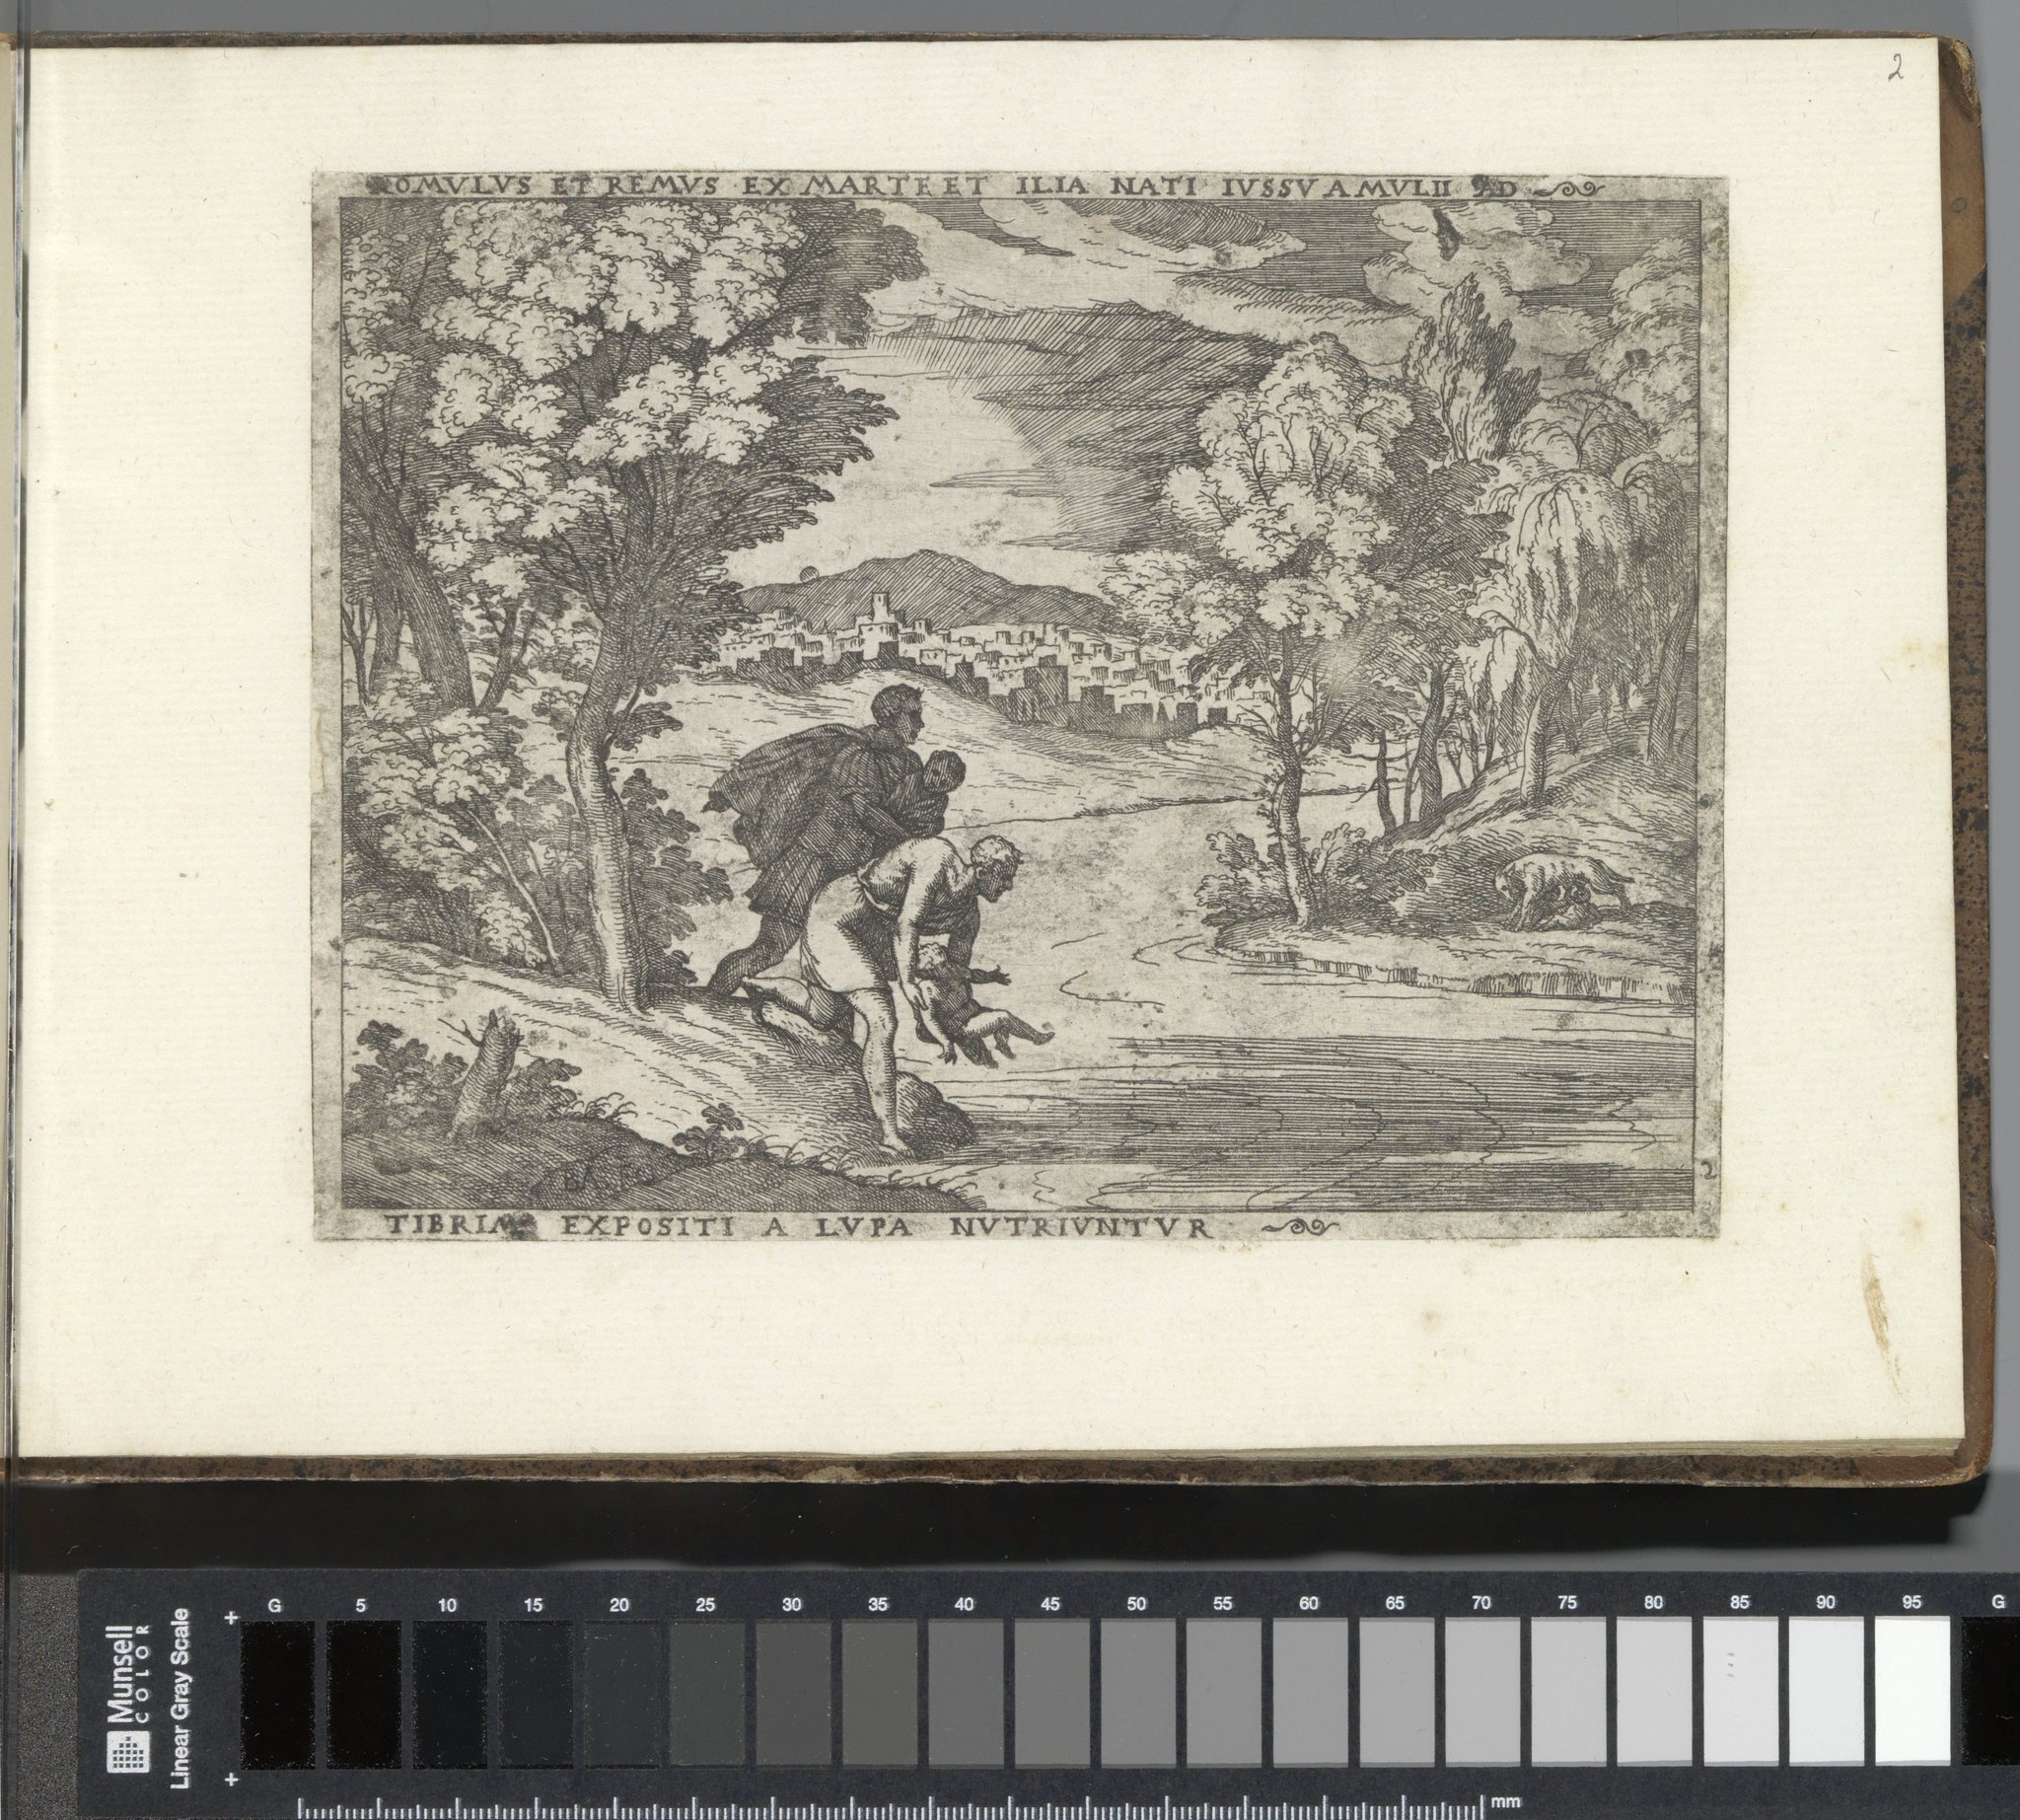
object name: album leaf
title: Leven van Romulus en Remus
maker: giovanni battista fontana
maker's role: draughtsman, painter, print maker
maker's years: 1524-1587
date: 1572-1573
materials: paper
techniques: etching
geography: italy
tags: romulus and remus are washed ashore and suckled by a she-wolf; 'lupa romana', river, romulus and remus, twin sons of rhea silvia by mars, are thrown into the tiber by order of amulius, (story of) romulus and remus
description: Twee mannen gooien Romulus en Remus, de tweelingzoontjes van Rhea Silvia, in de rivier de Tiber in opdracht van Amulius. Op de achtergrond rechts wordt de tweeling gezoogd door een wolvin, de Lupa Capitolina. De prent maakt deel uit van een album.